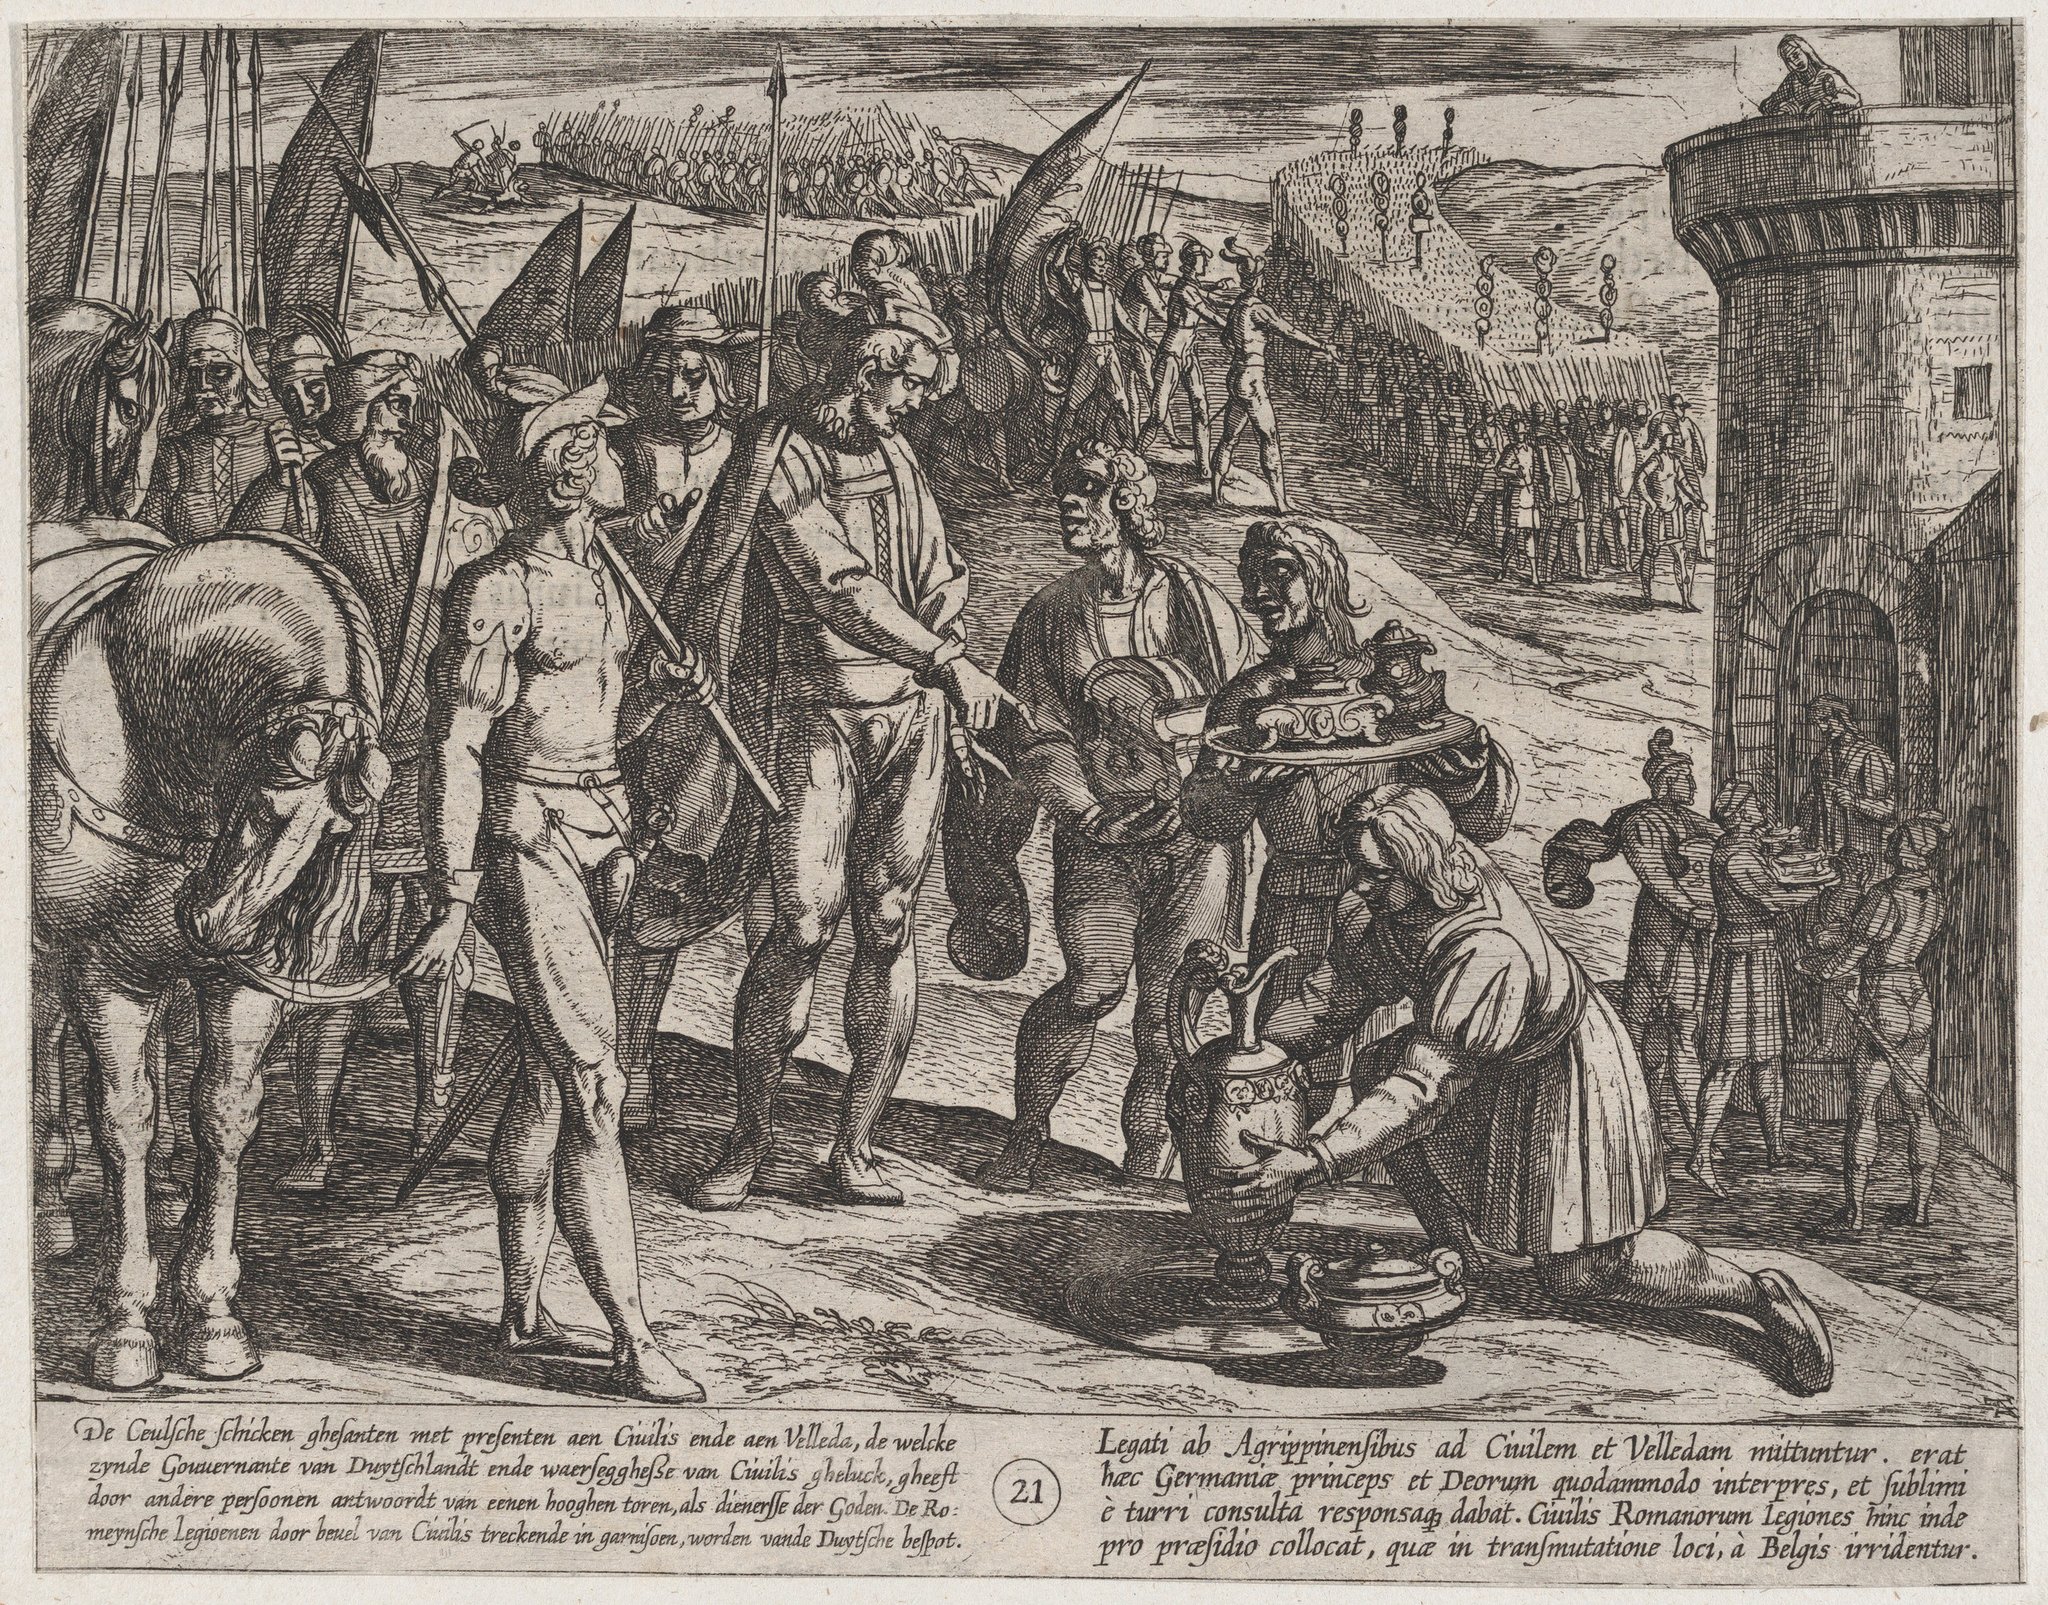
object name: print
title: Plate 21: Envoys from Cologne Bring Presents to Civilis, from The War of the Romans Against the Batavians (Romanorvm et Batavorvm societas)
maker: antonio tempesta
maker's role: artist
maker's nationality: italian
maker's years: 1555-1630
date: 1611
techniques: etching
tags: soldiers,weapons,men,horses